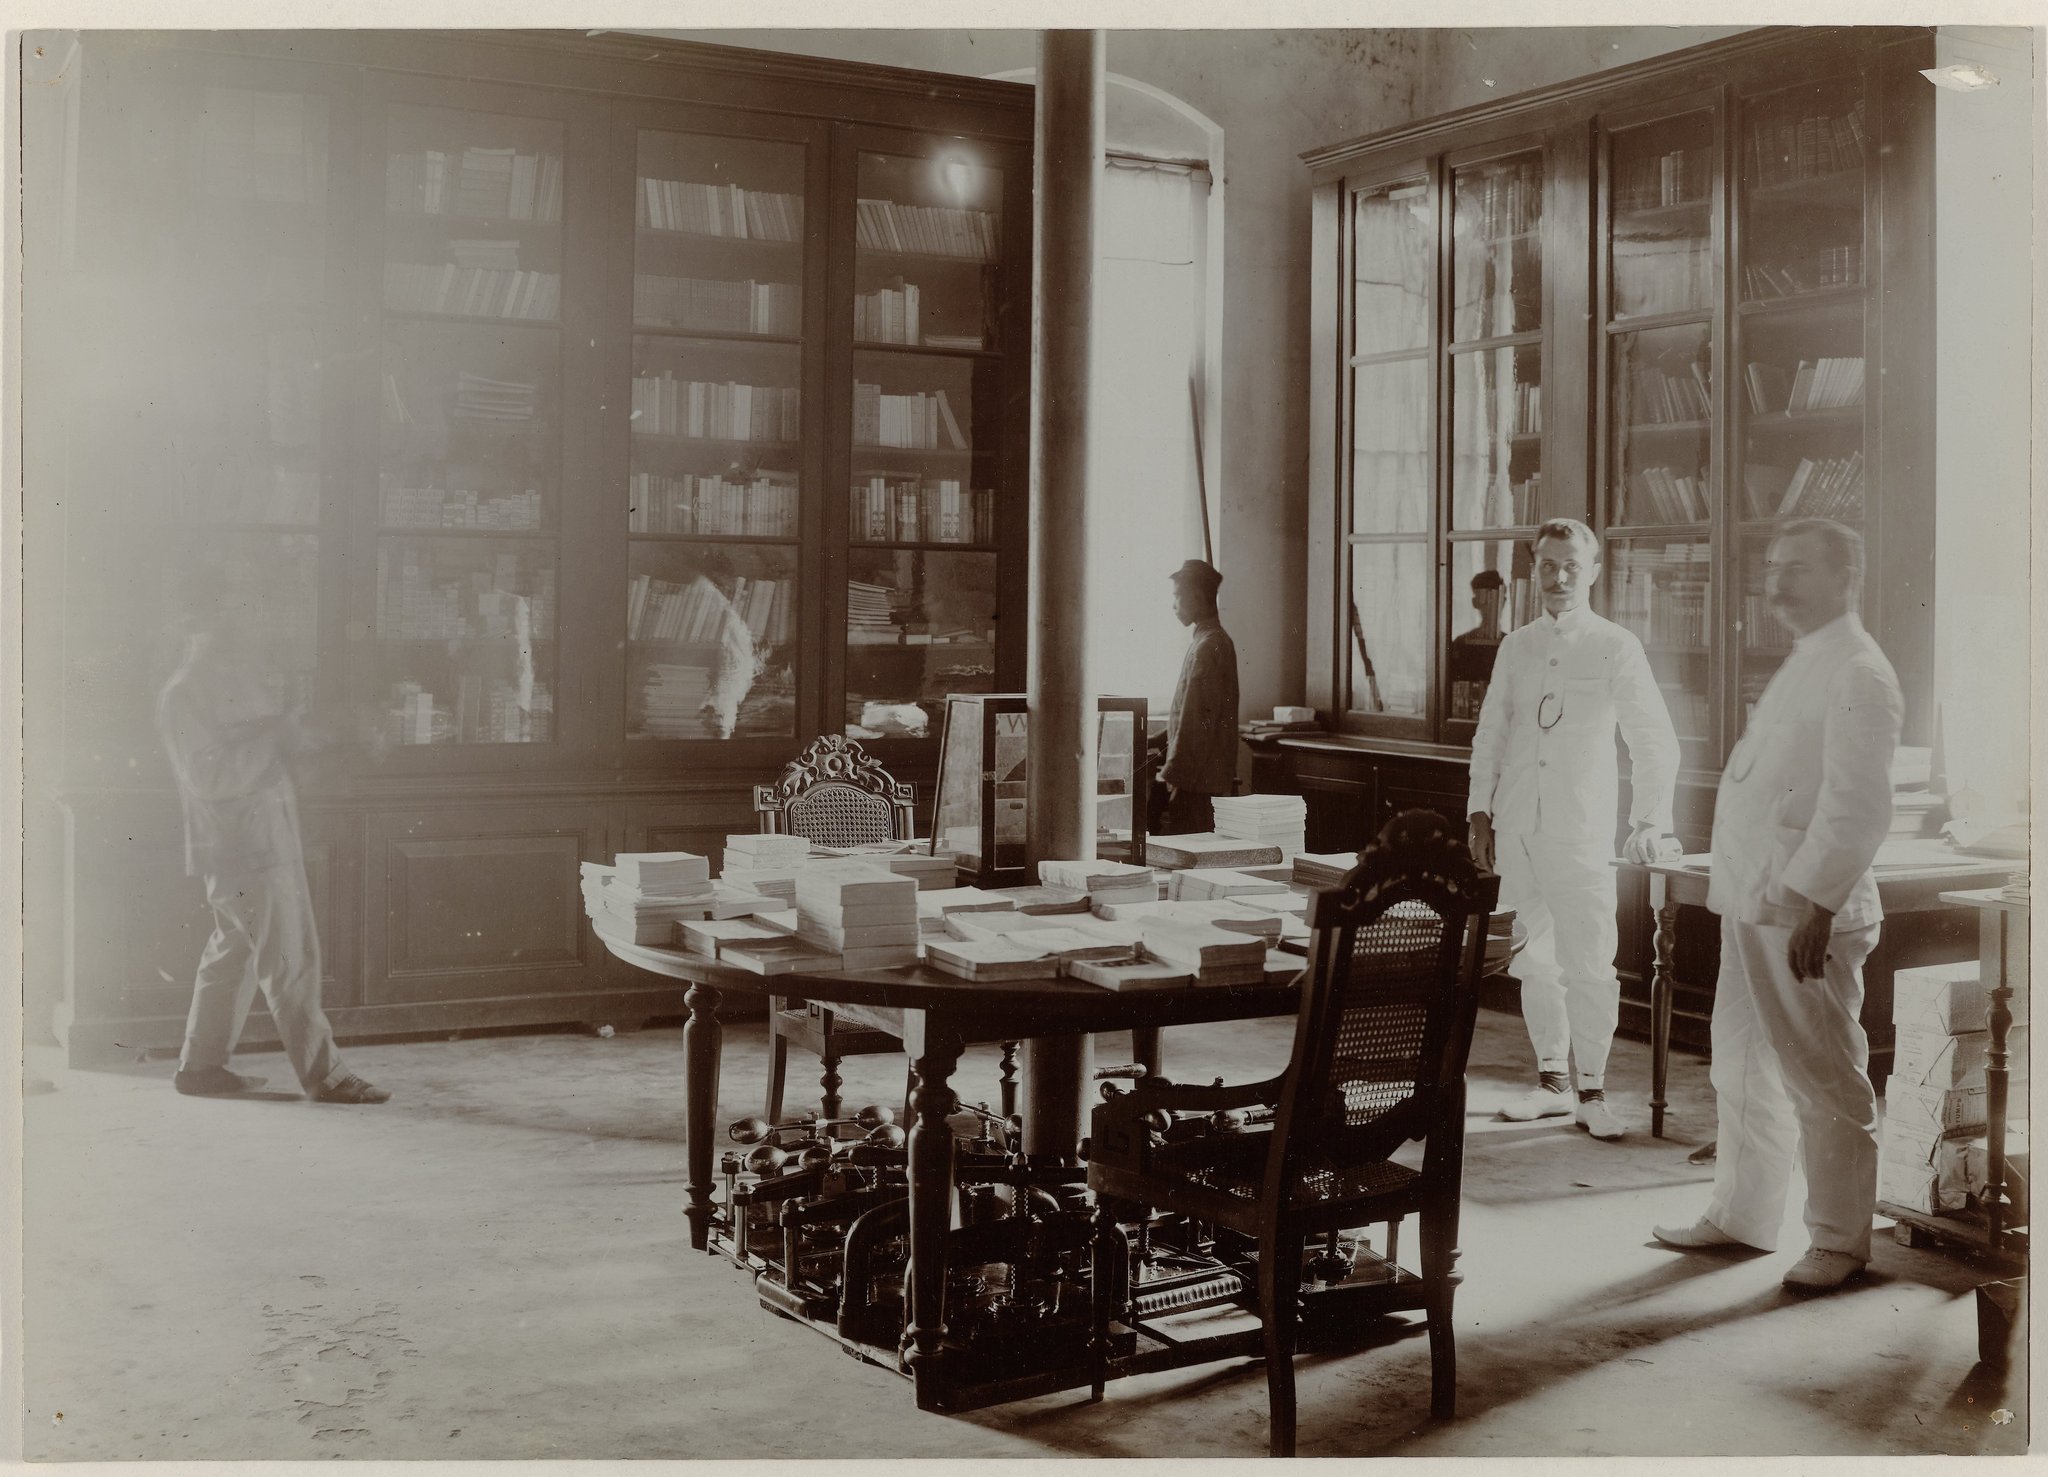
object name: photograph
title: Winkel van de Deli Courant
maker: Anonymous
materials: photographic support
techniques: collodion silver print, gelatin silver print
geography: medan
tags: dutch east indies, the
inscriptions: inscription: ‘winkel’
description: Gezicht in de winkel van de drukkerij van de Deli Courant te Medan, centraal een tafel met nieuwe uitgaven, langs de muren kasten met boeken. Met staande Europese en Javaanse medewerkers. Onderdeel van een aparte groep van negen foto's uit 1908 binnen de gehele groep van 49 losse zwart-wit foto's van verschillend formaat over de uitgeverij en drukkerij van de krant Deli Courant in Medan in de periode 1885-1947.